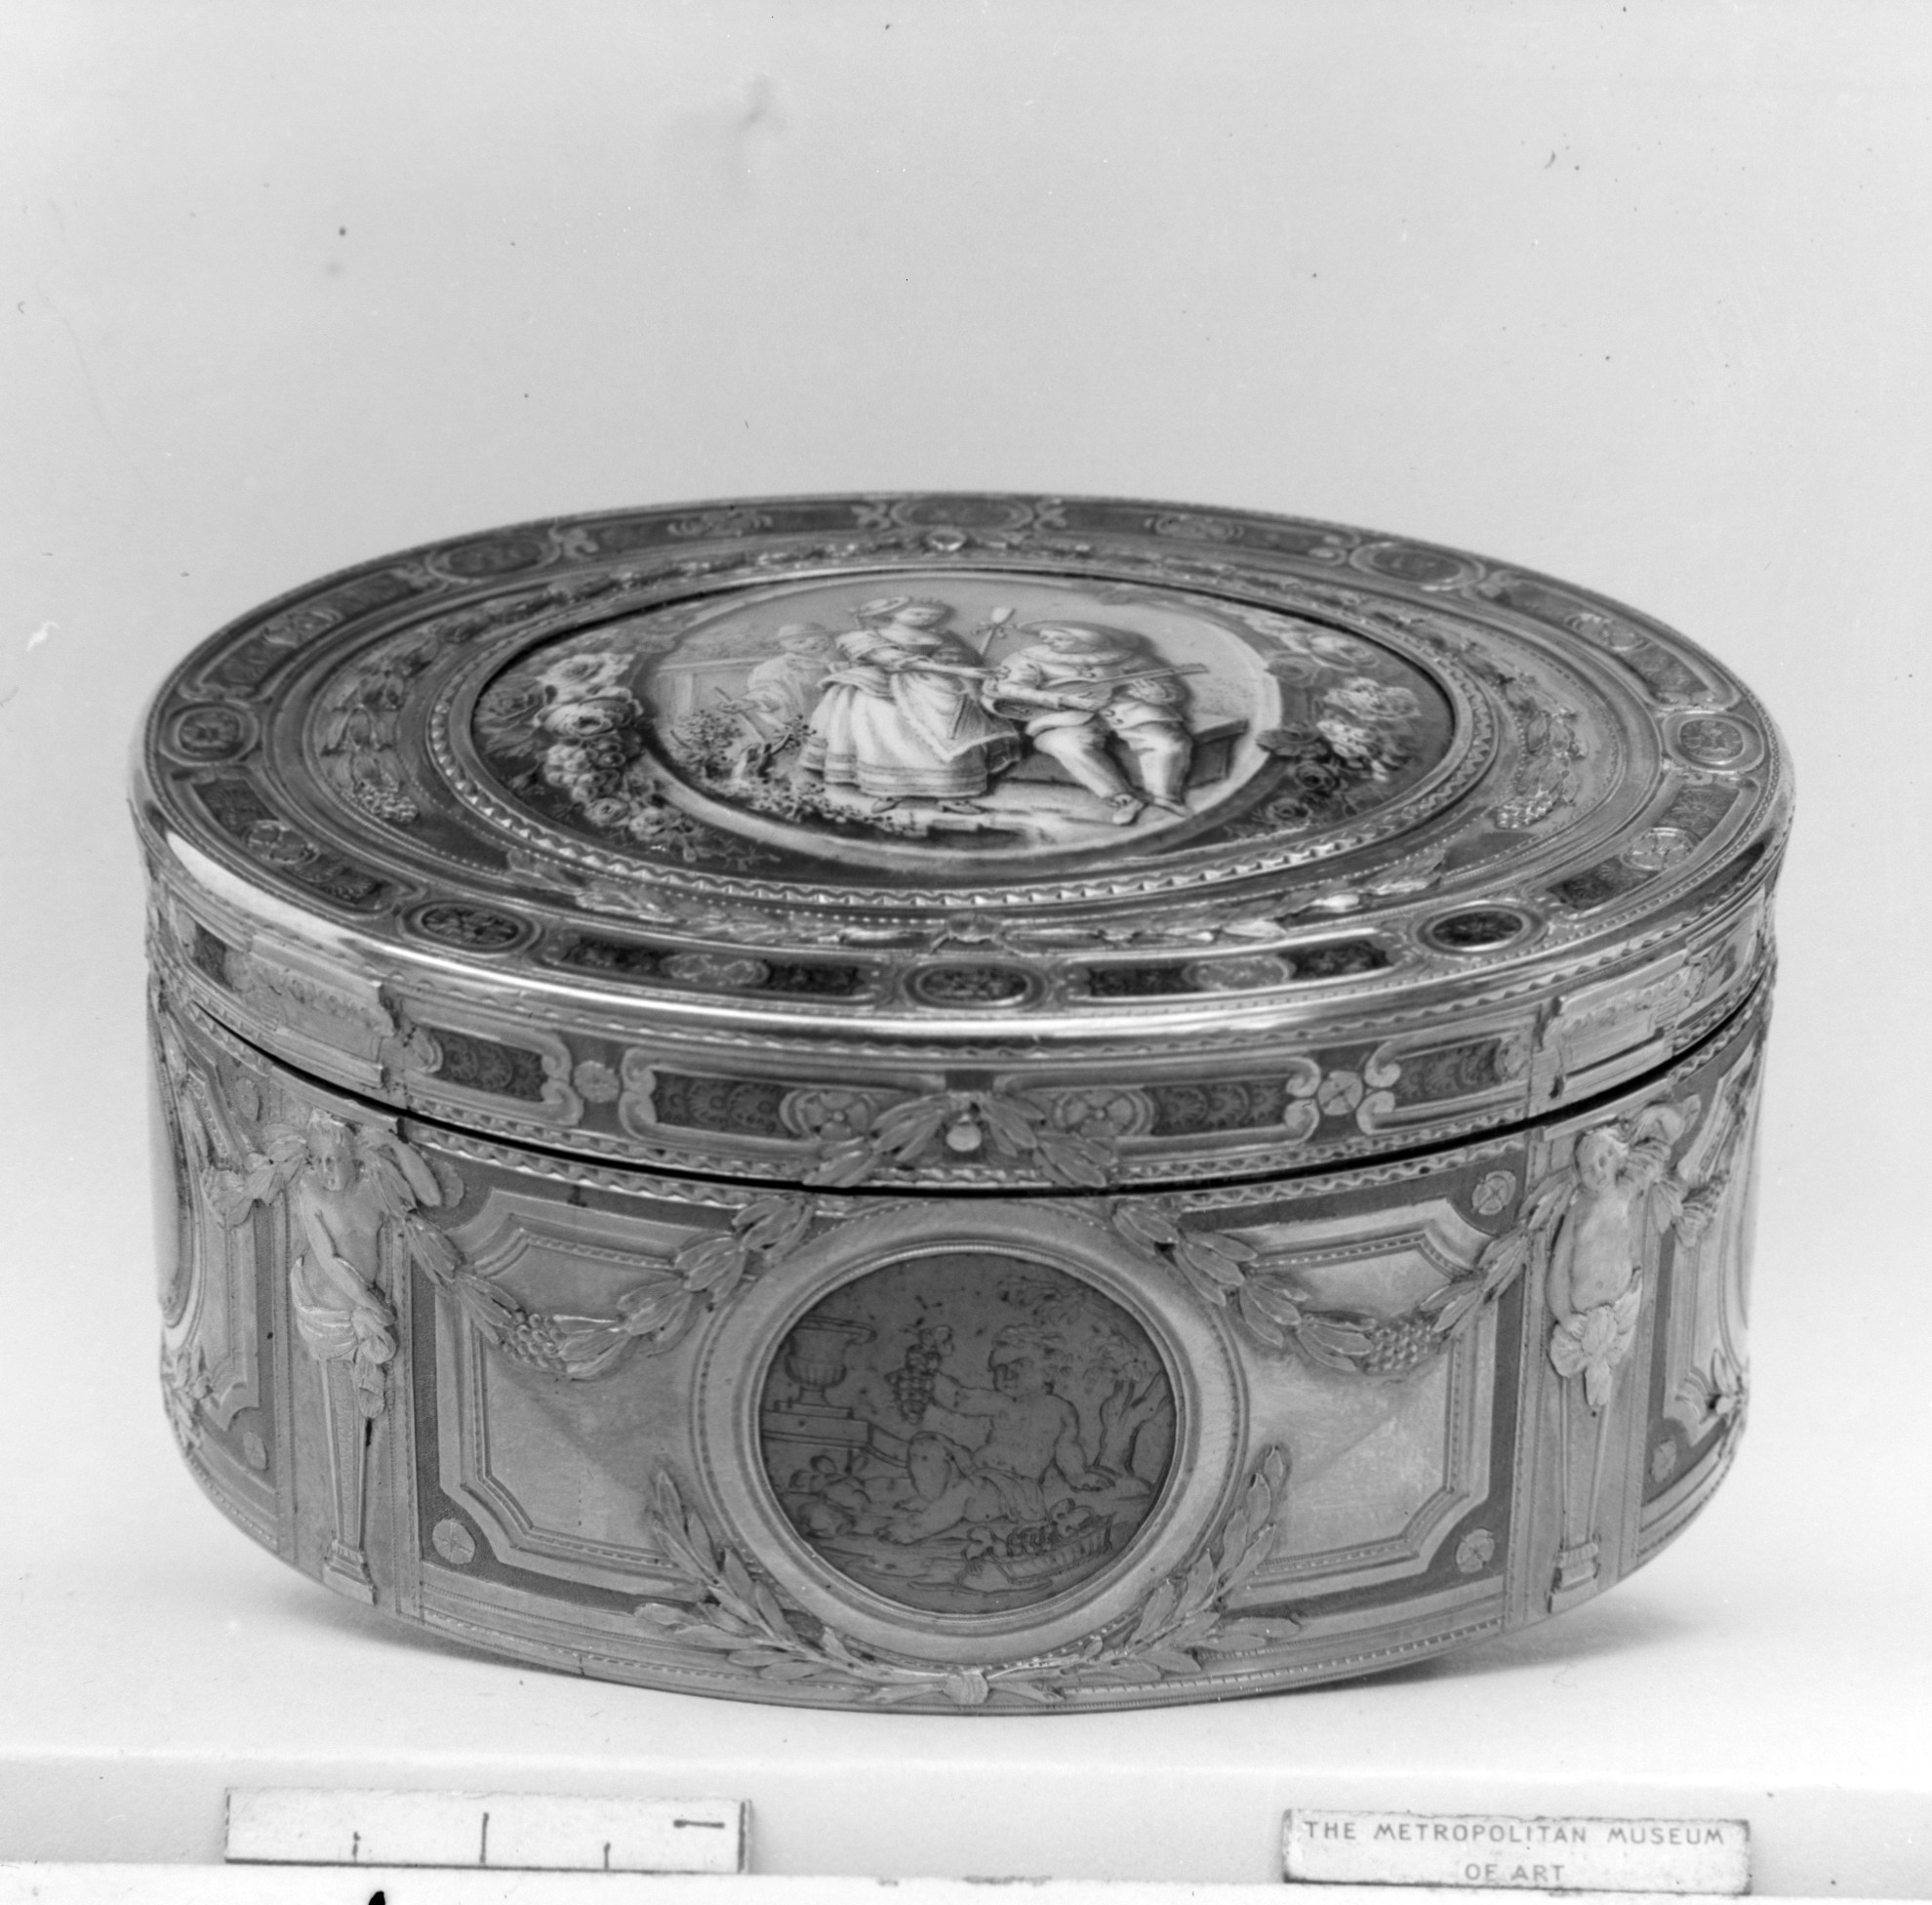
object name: snuffbox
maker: jean-joseph barrière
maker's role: maker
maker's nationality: french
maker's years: 1733-1833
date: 1765-1766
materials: enamel, gold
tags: musical instruments,men,women